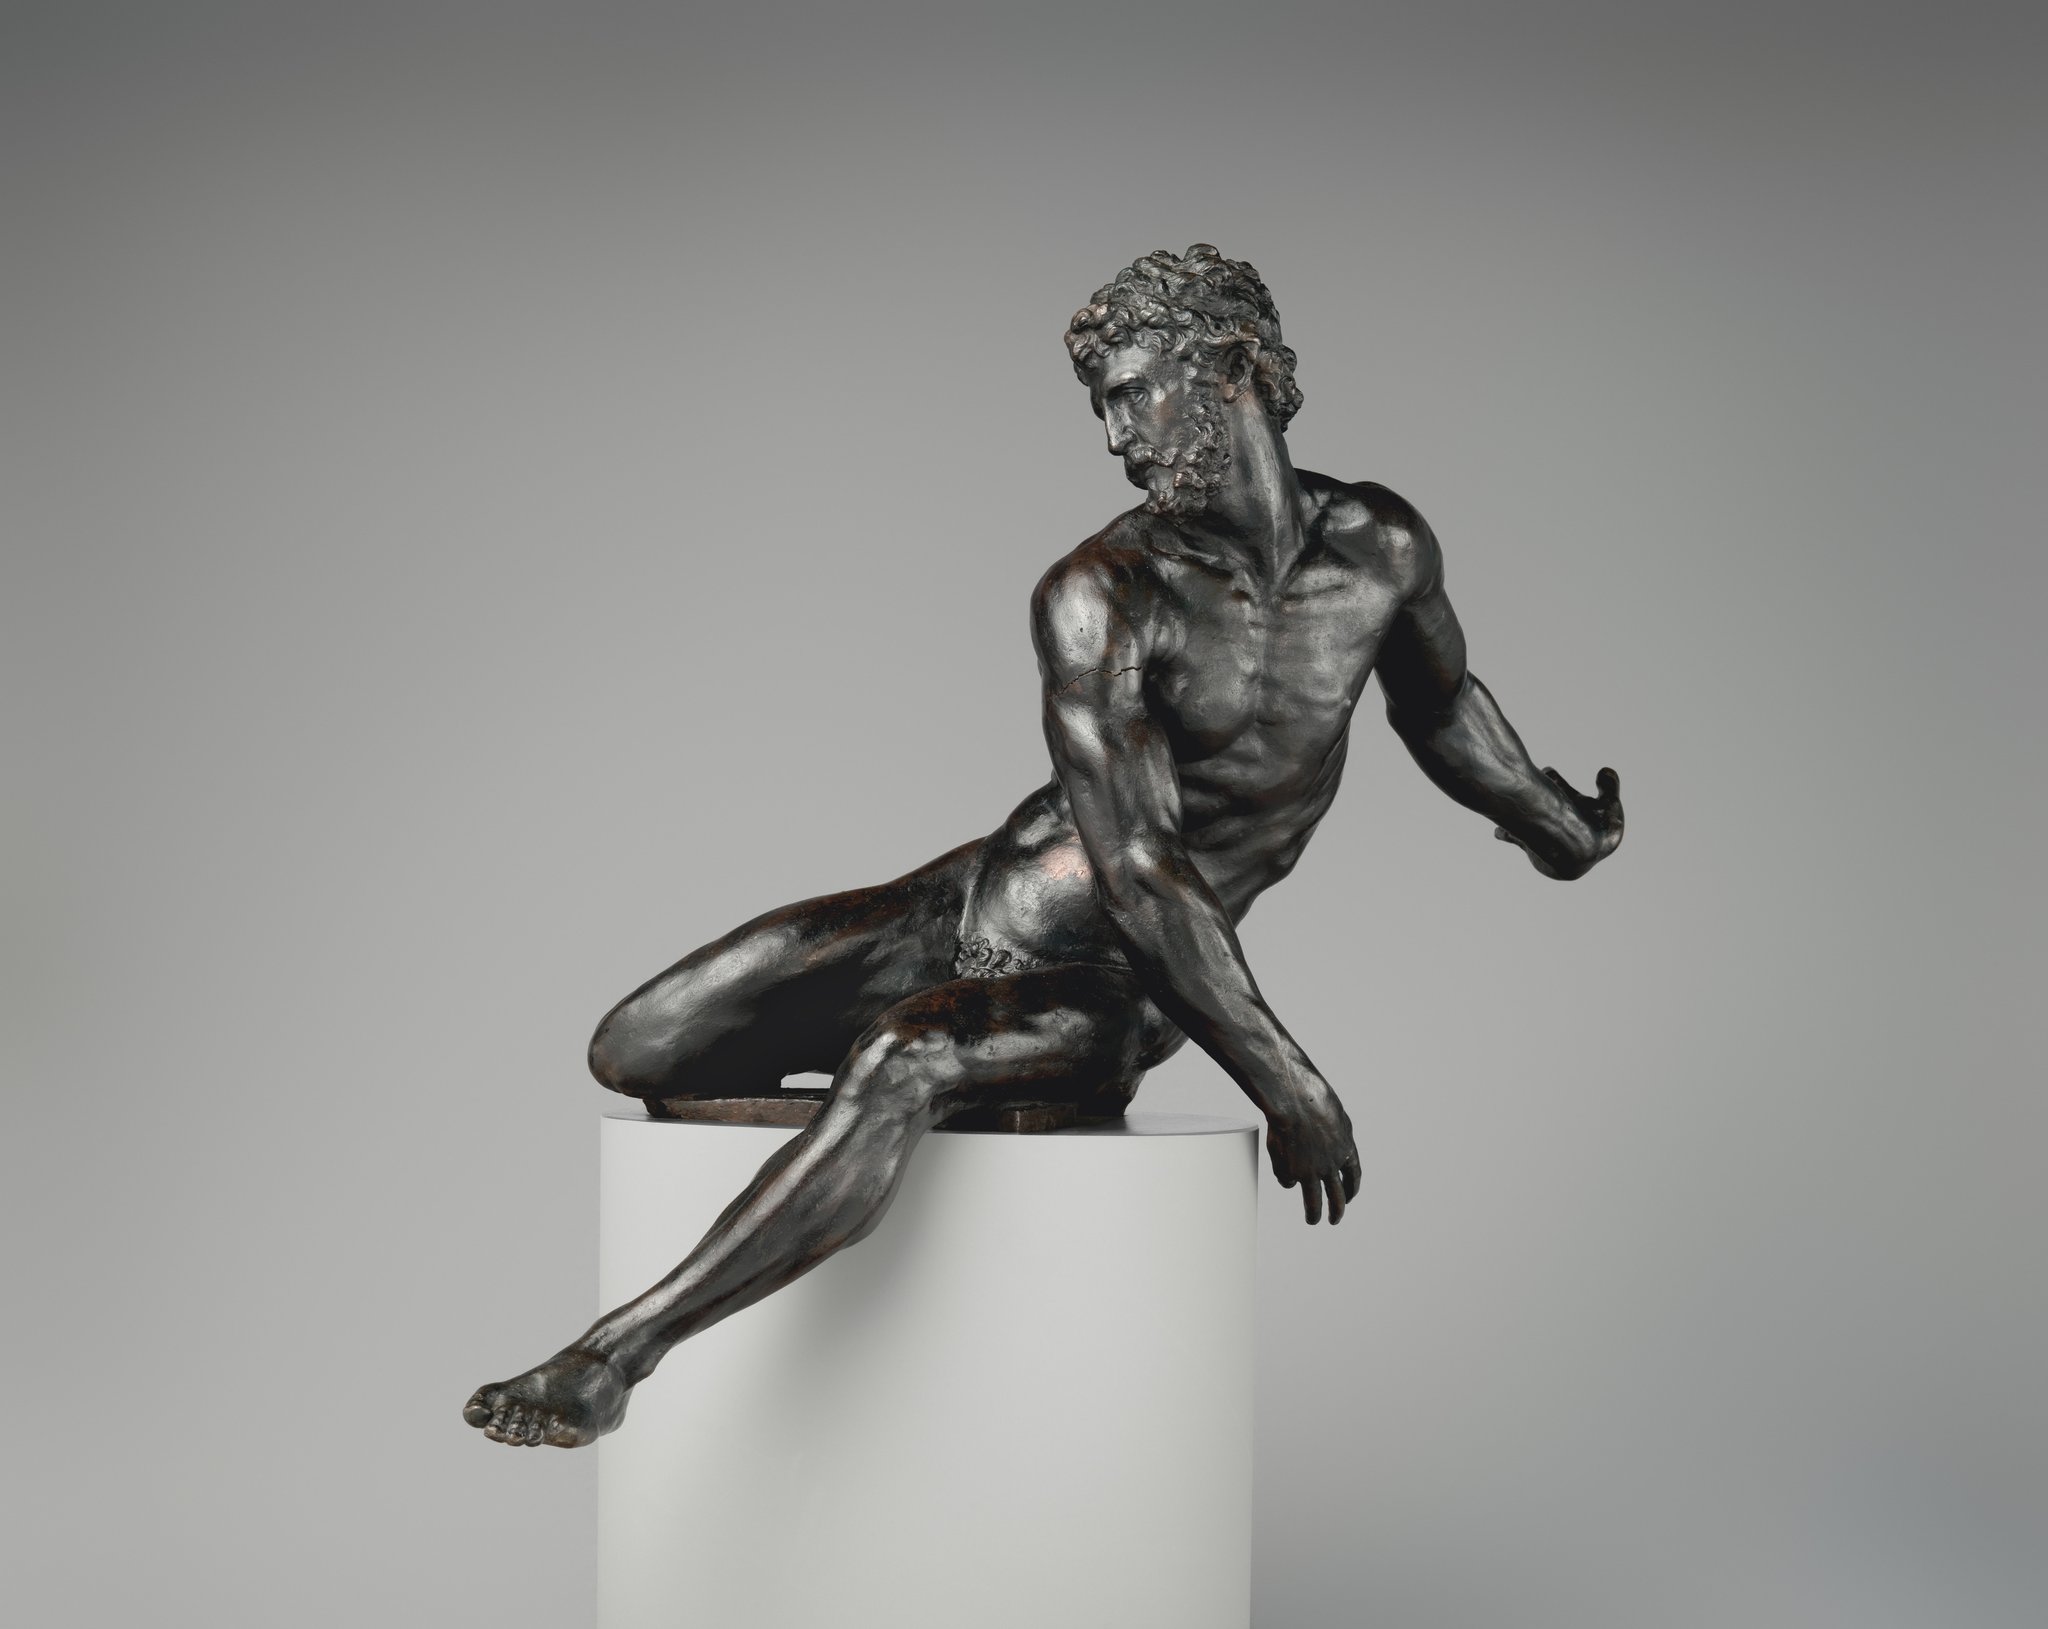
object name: statuette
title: Seated male figure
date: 1534-1566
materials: bronze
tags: male nudes